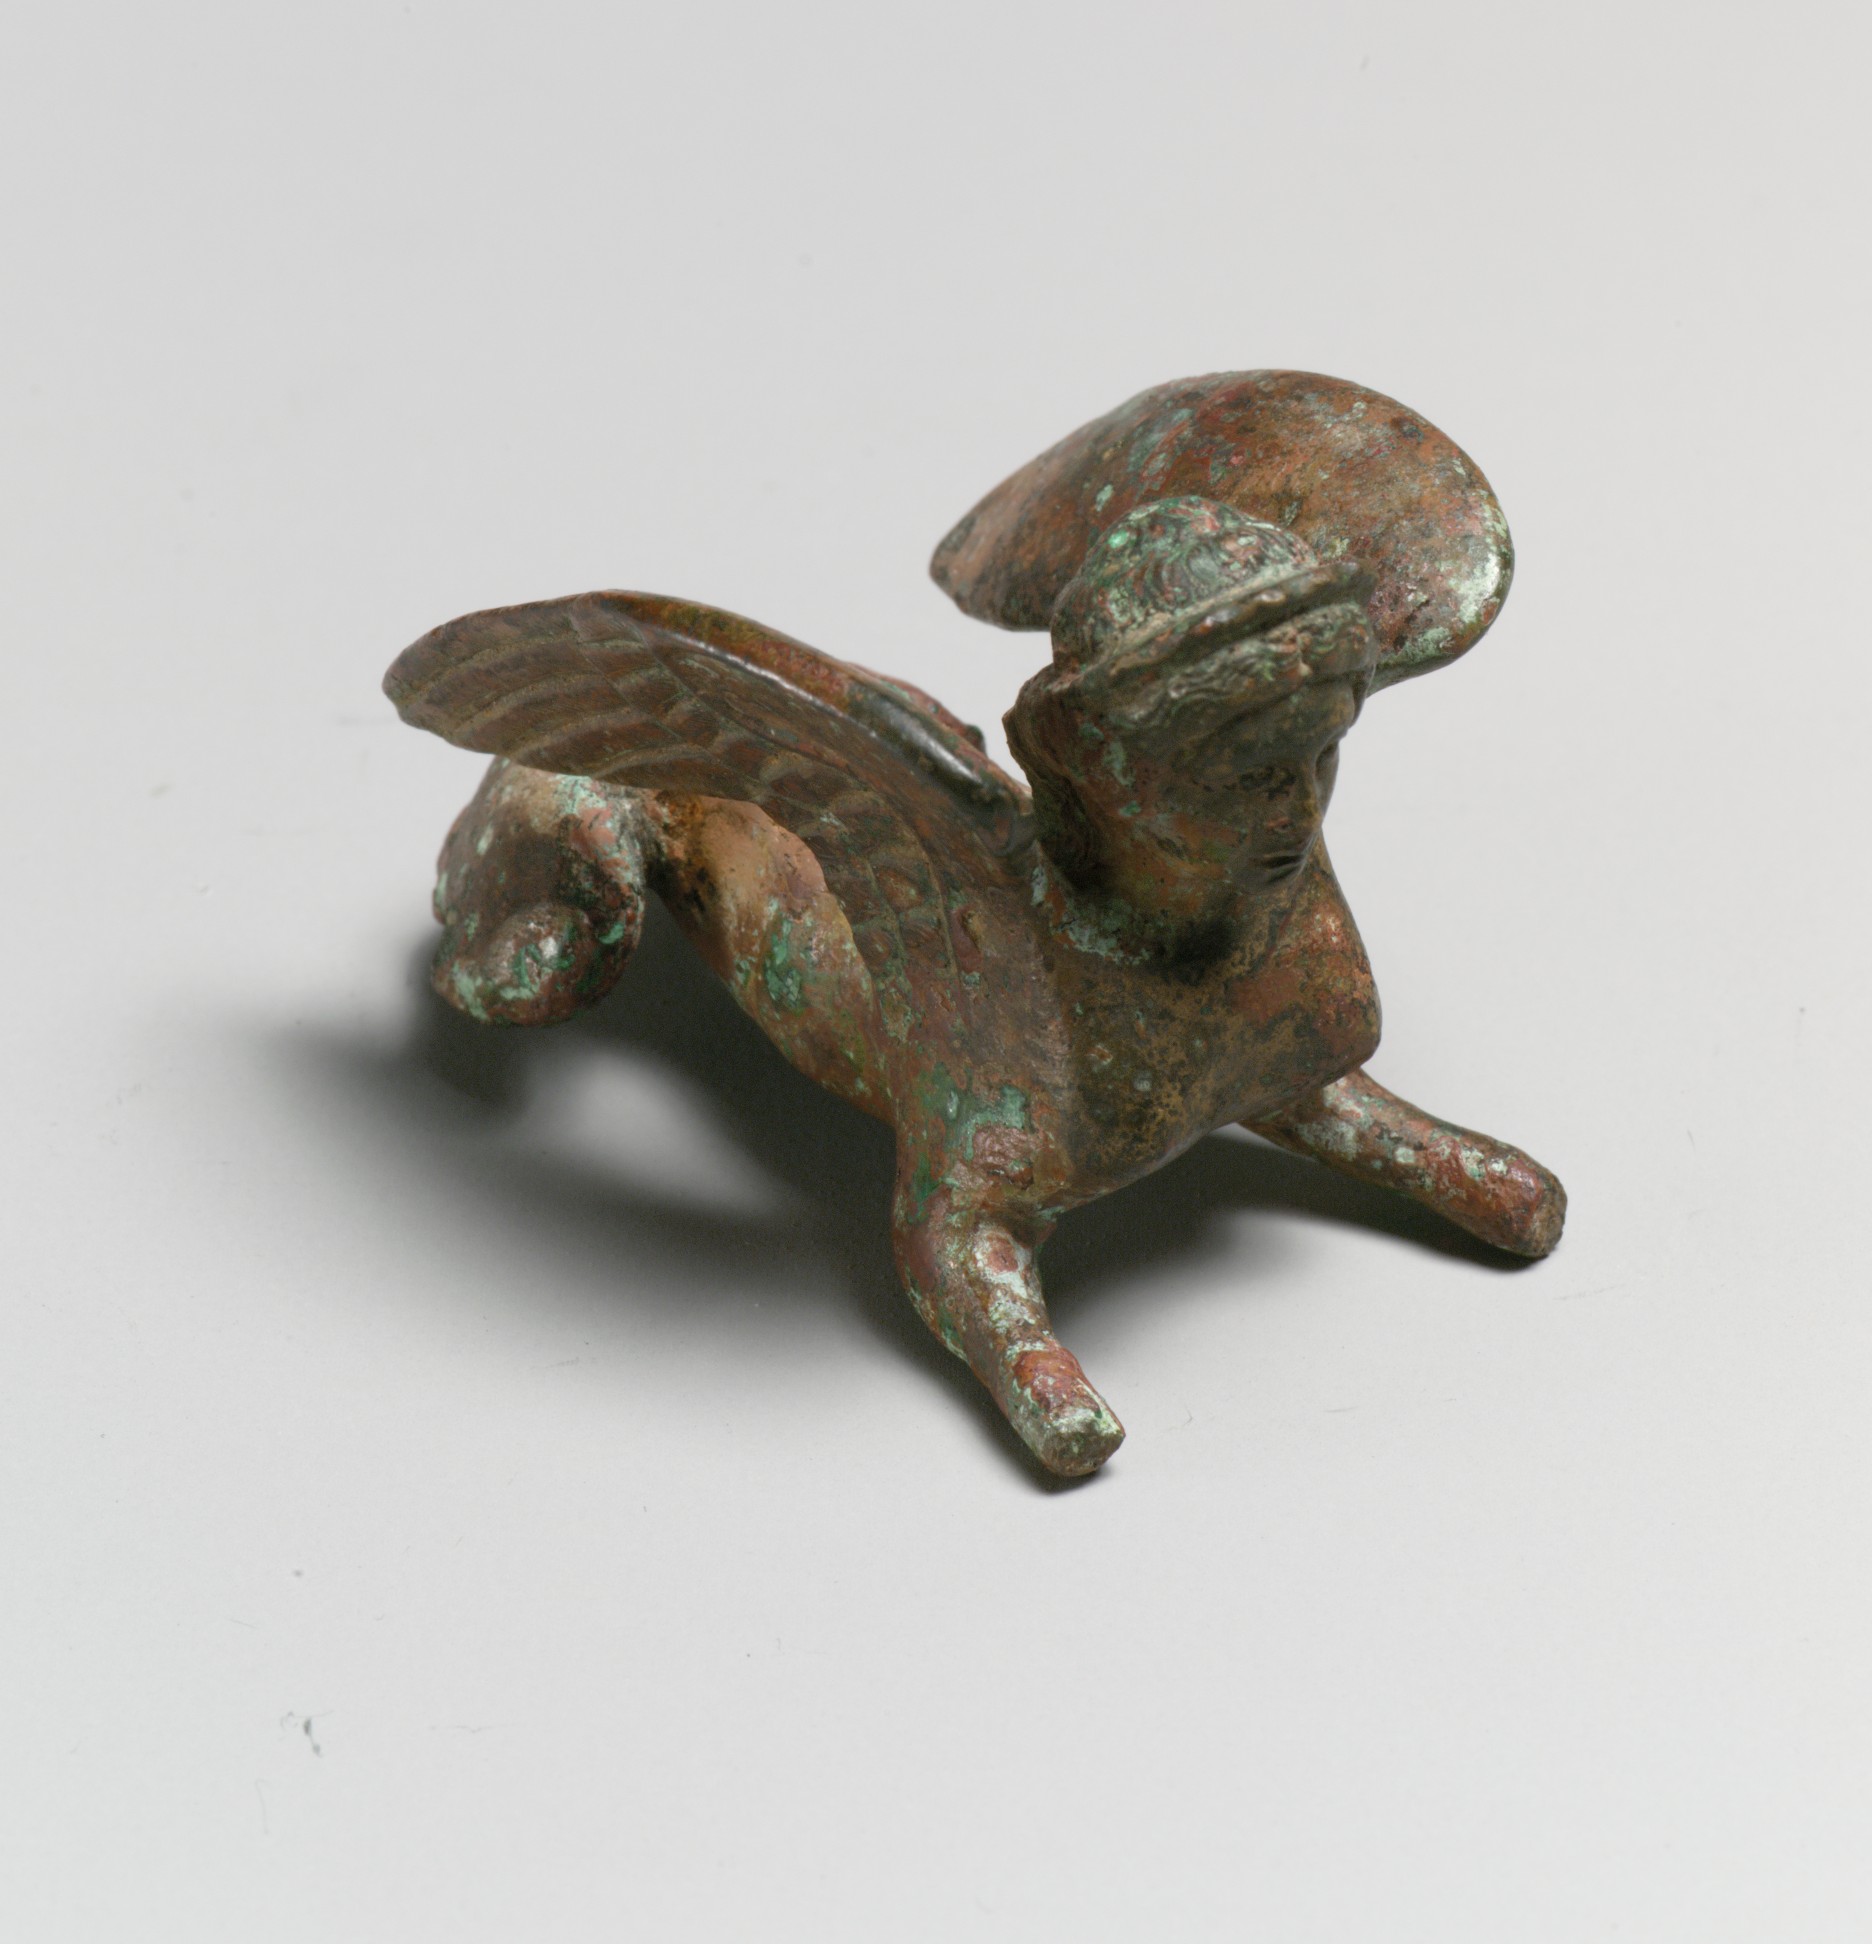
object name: statuette of a sphinx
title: Bronze statuette of a sphinx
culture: greek or roman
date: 1-100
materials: bronze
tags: sphinx